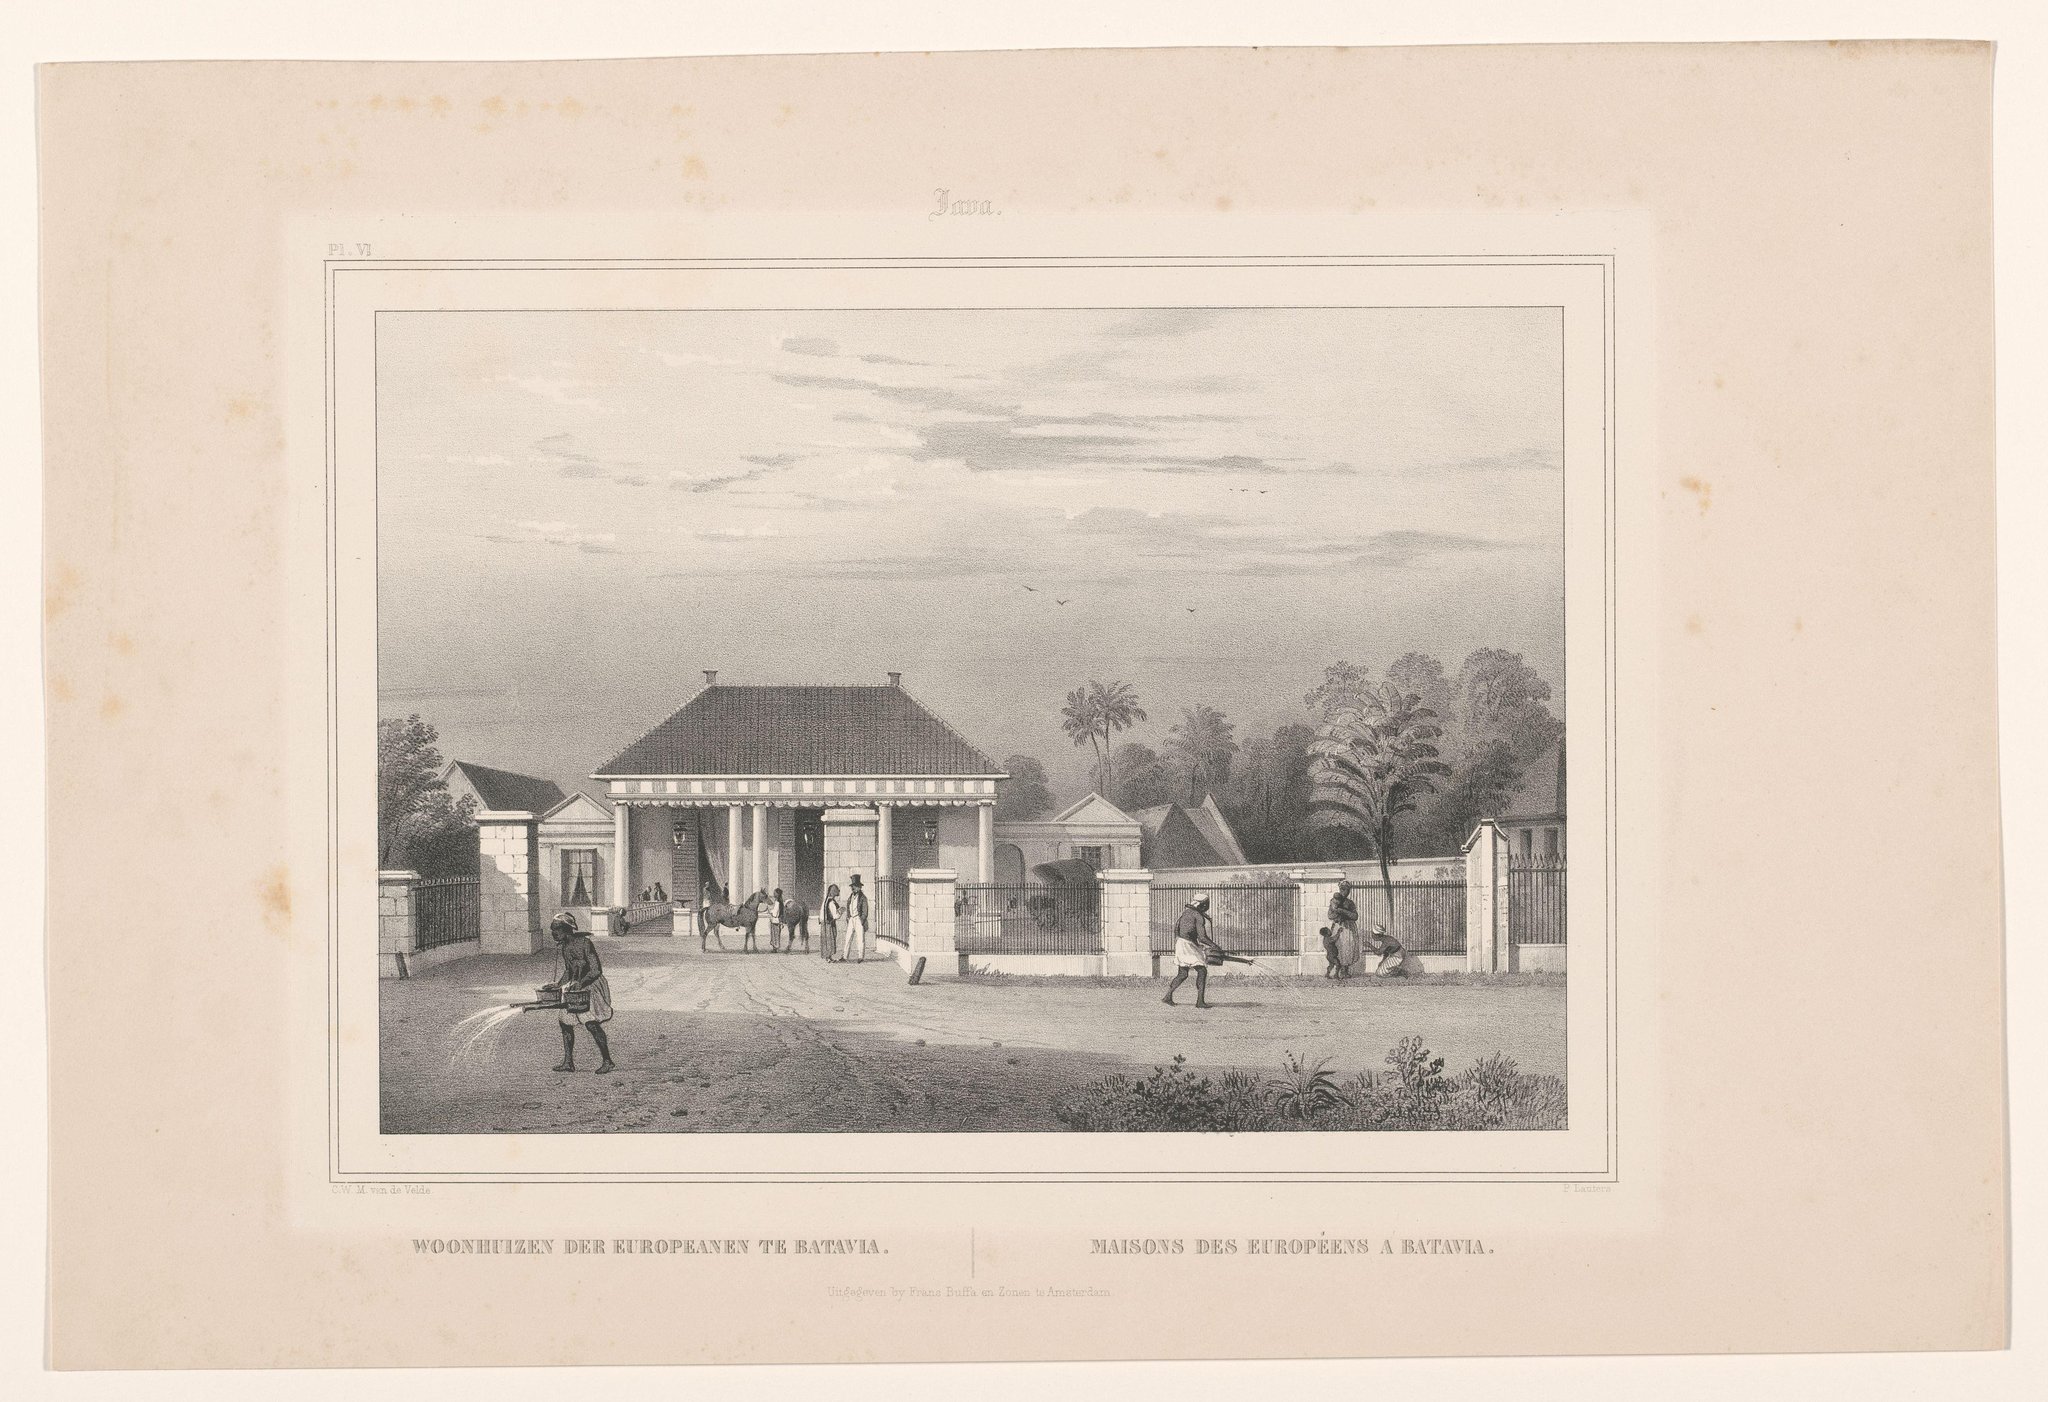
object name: print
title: Woning van een Europeaan op Batavia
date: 1843-1845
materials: paper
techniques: lithograph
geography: amsterdam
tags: watering plants, country-house, batavia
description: De heer des huizes staat voor het huis en is in gesprek met een Javaanse man. Op de oprijlaan zijn twee mannen bezig planten water te geven. Genummerd linksboven: Pl. VI. De prent maakt deel uit van een omslag met dertien bladen.